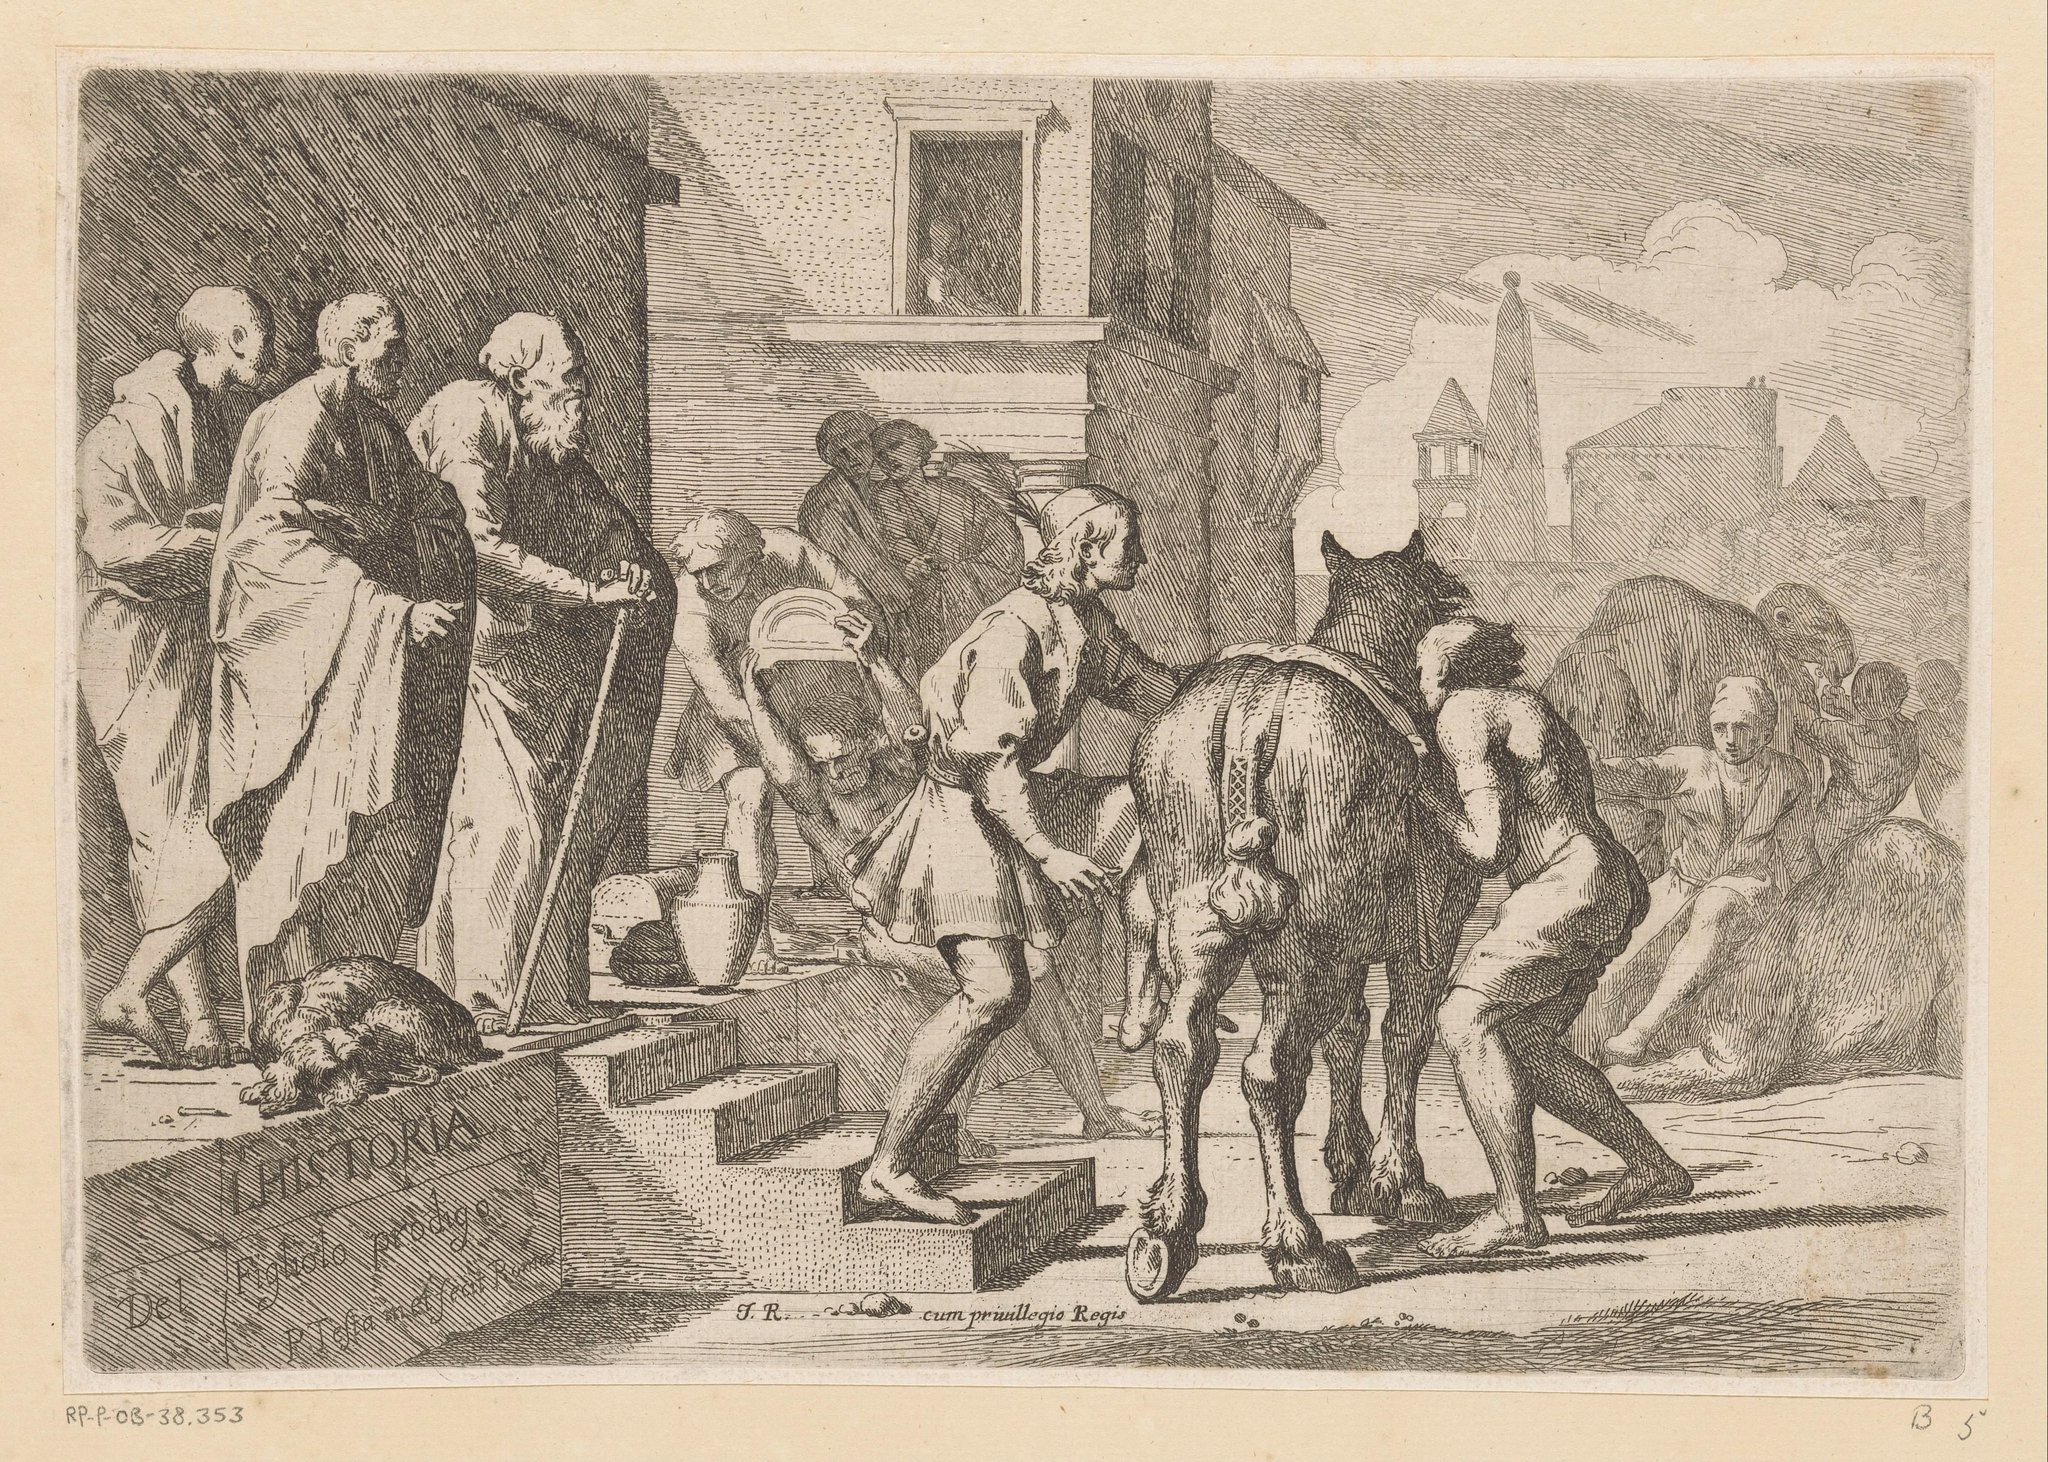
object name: print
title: L' Historia Del Figliolo prodigo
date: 1621-1650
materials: paper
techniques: etching, intaglio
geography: rome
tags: hoofed animals: dromedary, horse, leave-taking and departure of the prodigal son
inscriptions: collector's mark: Lugt 240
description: De verloren zoon stapt op zijn paard en verlaat zijn ouderlijk huis. Links drie mannen en rechts op de achtergrond drie figuren met twee dromedarissen.